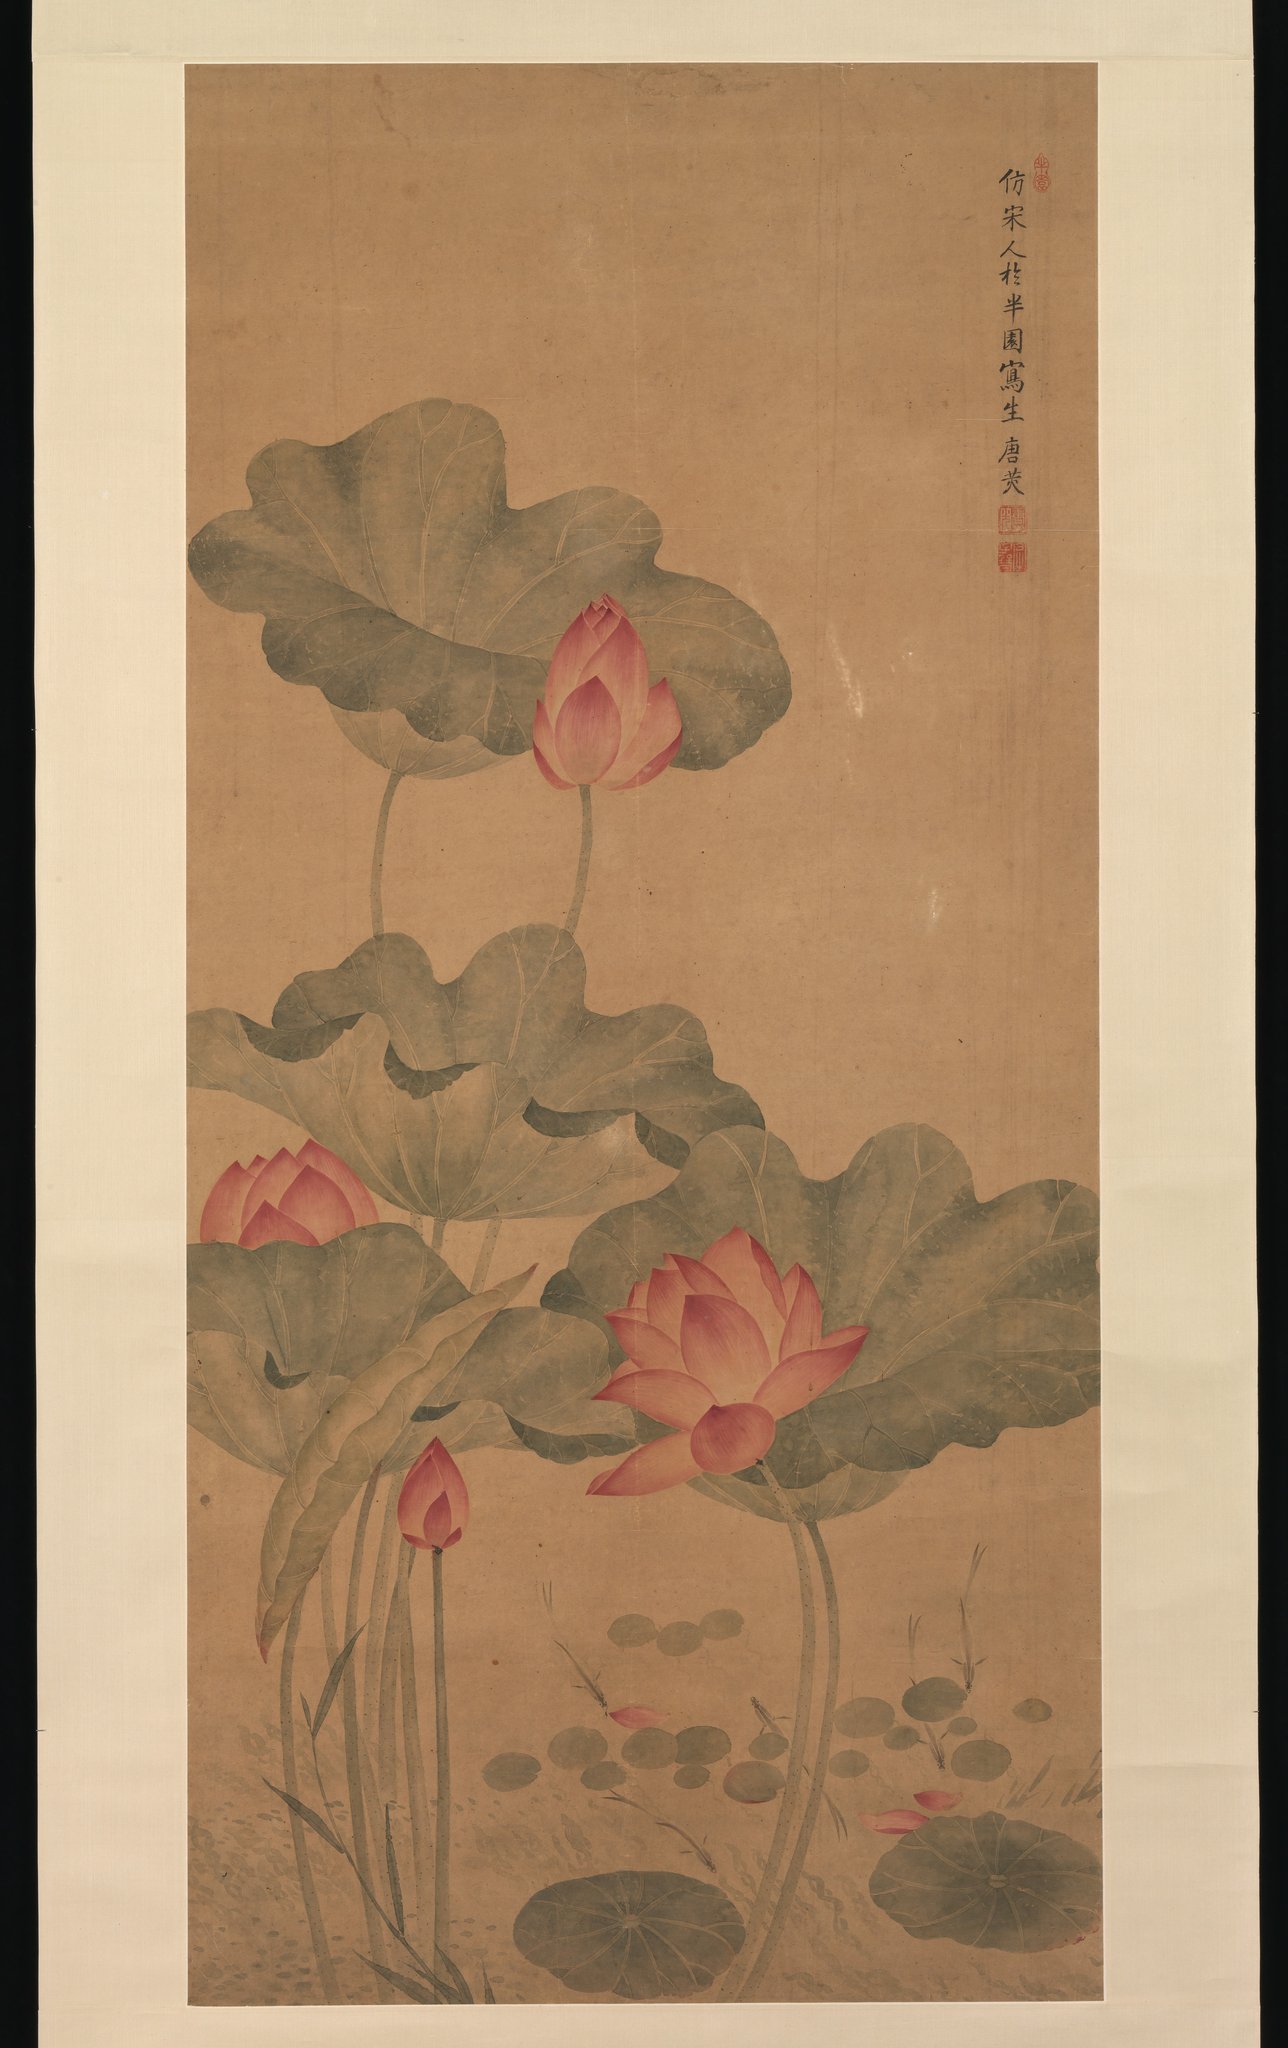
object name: hanging scroll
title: Red lotus and fish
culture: chinese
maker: tang guang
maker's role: artist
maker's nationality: chinese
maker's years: 1660-1700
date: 1650-1700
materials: ink, paper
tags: lotuses